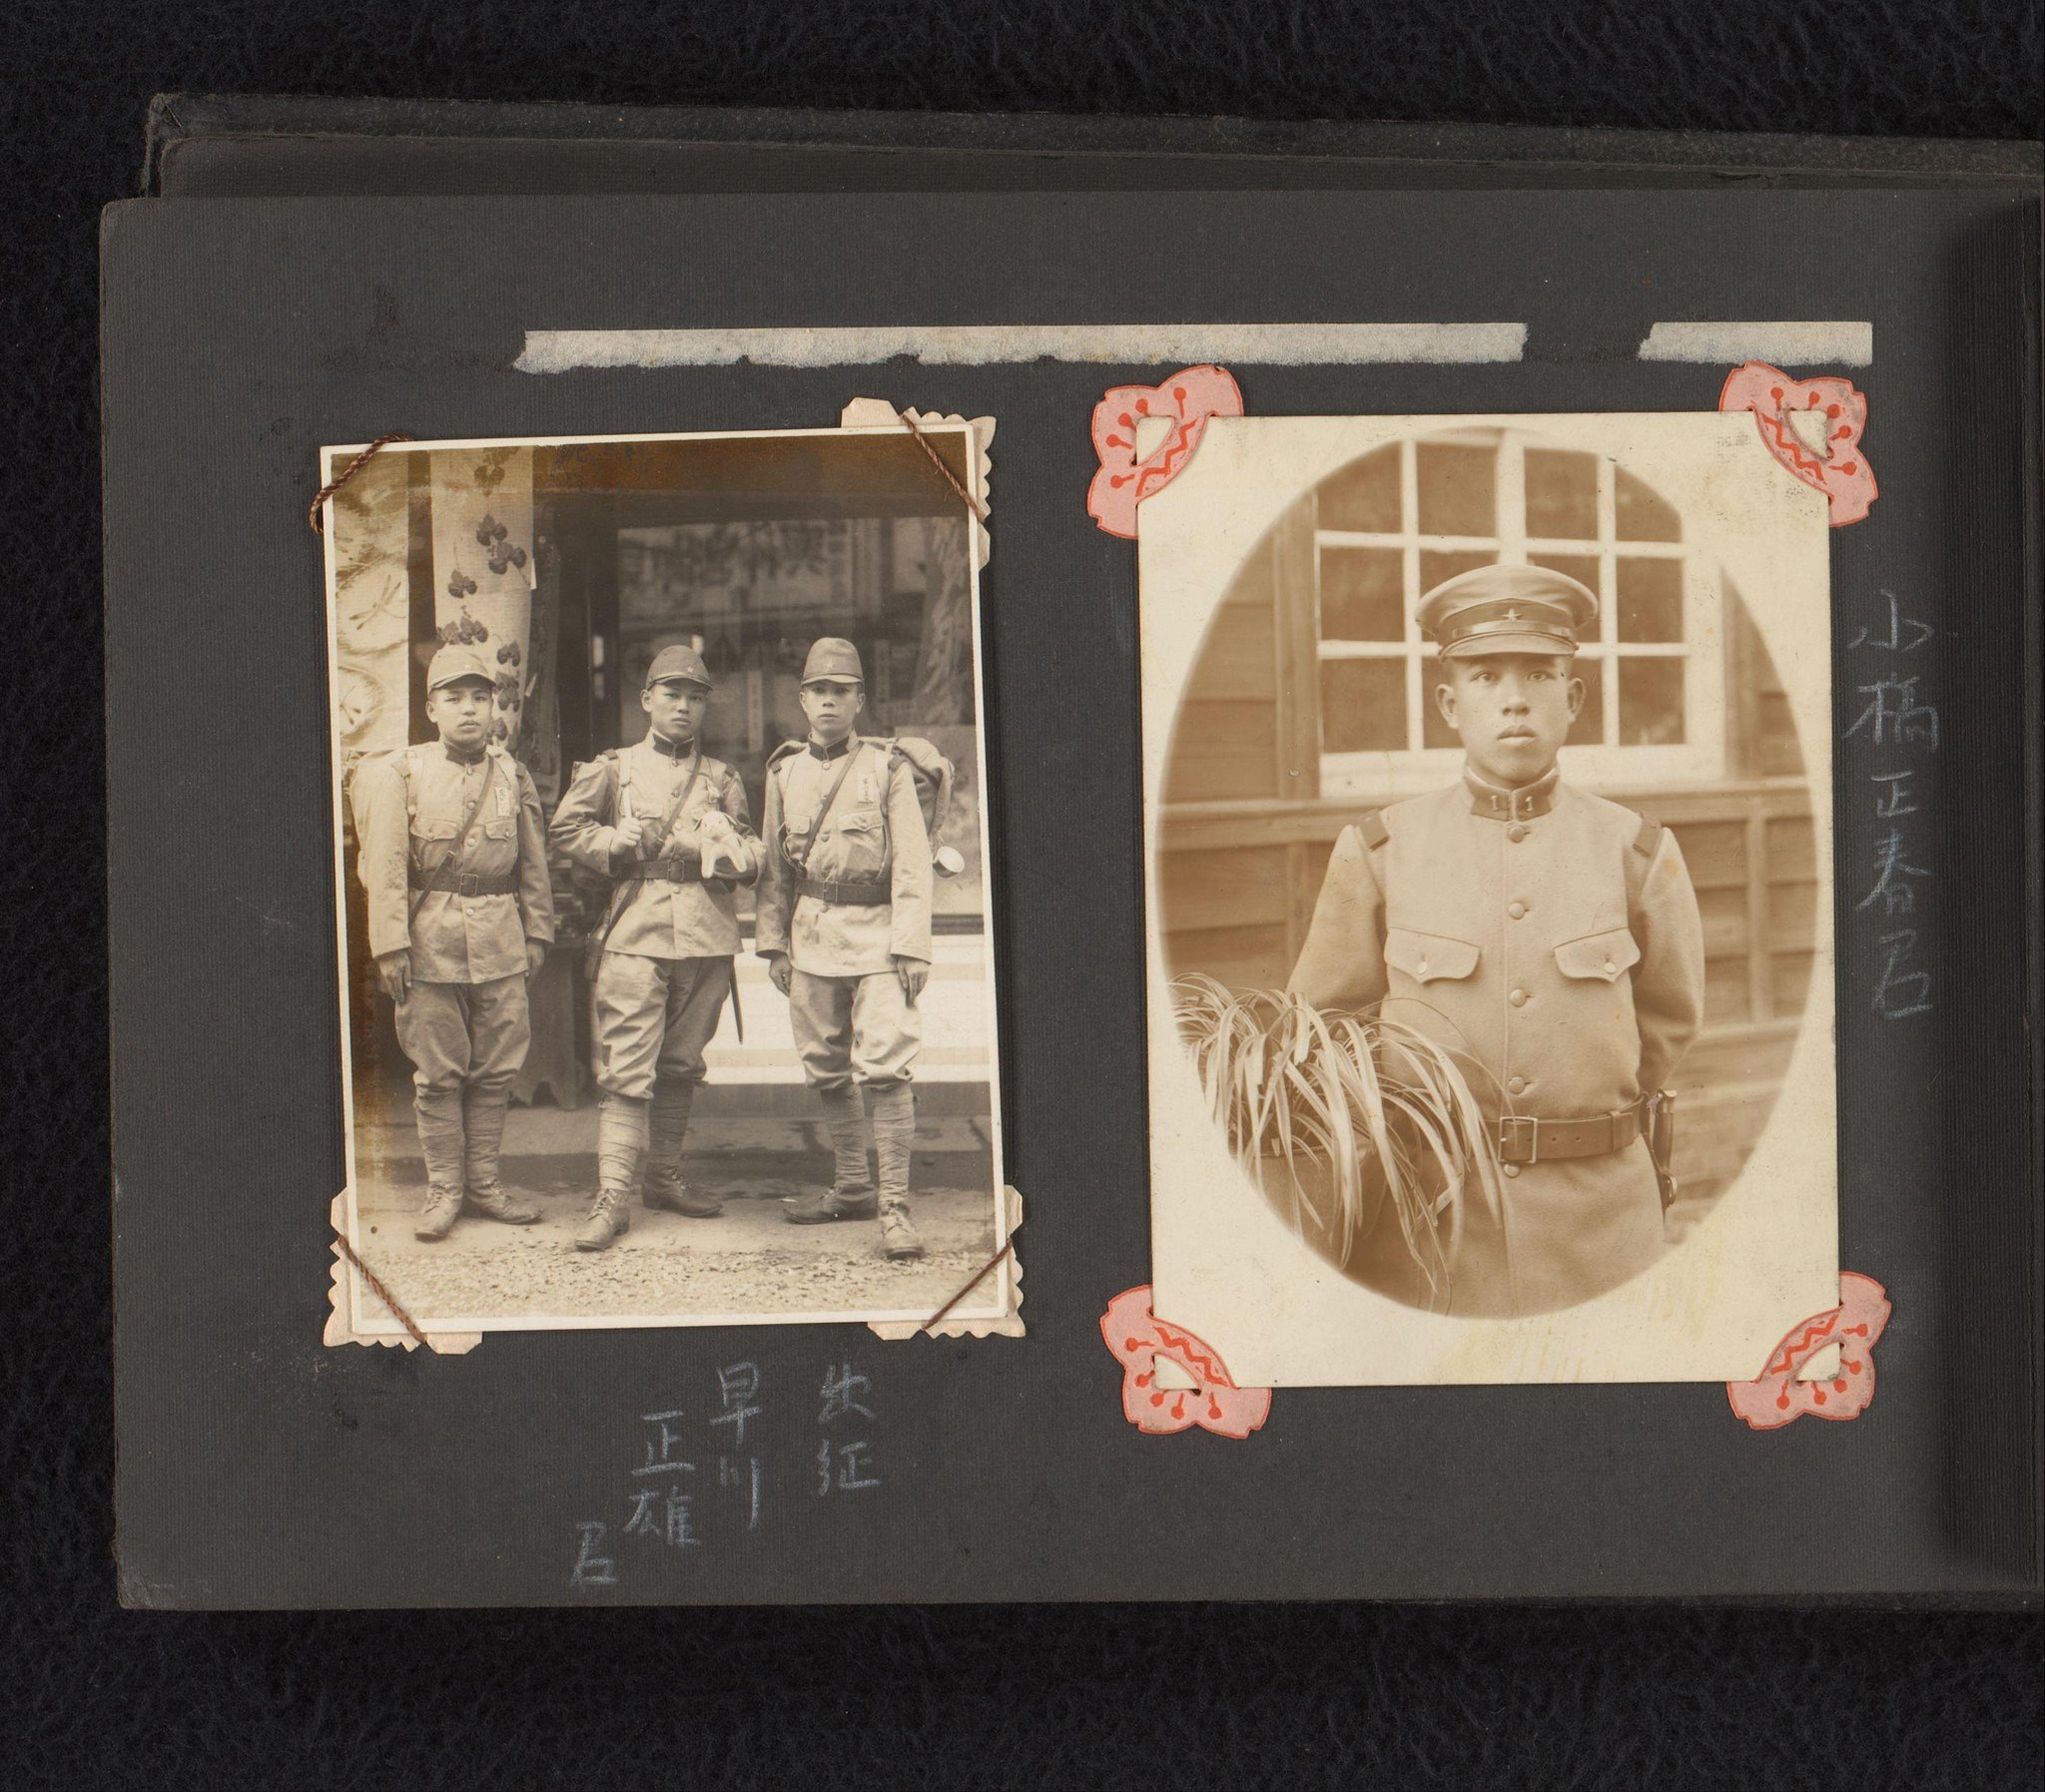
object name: photograph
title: Portretten van onbekende Japanse soldaten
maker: Anonymous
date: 1937-1941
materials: paper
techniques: gelatin silver print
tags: anonymous historical person portrayed, the soldier; the soldier's life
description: Deze foto's zijn onderdeel van een album.